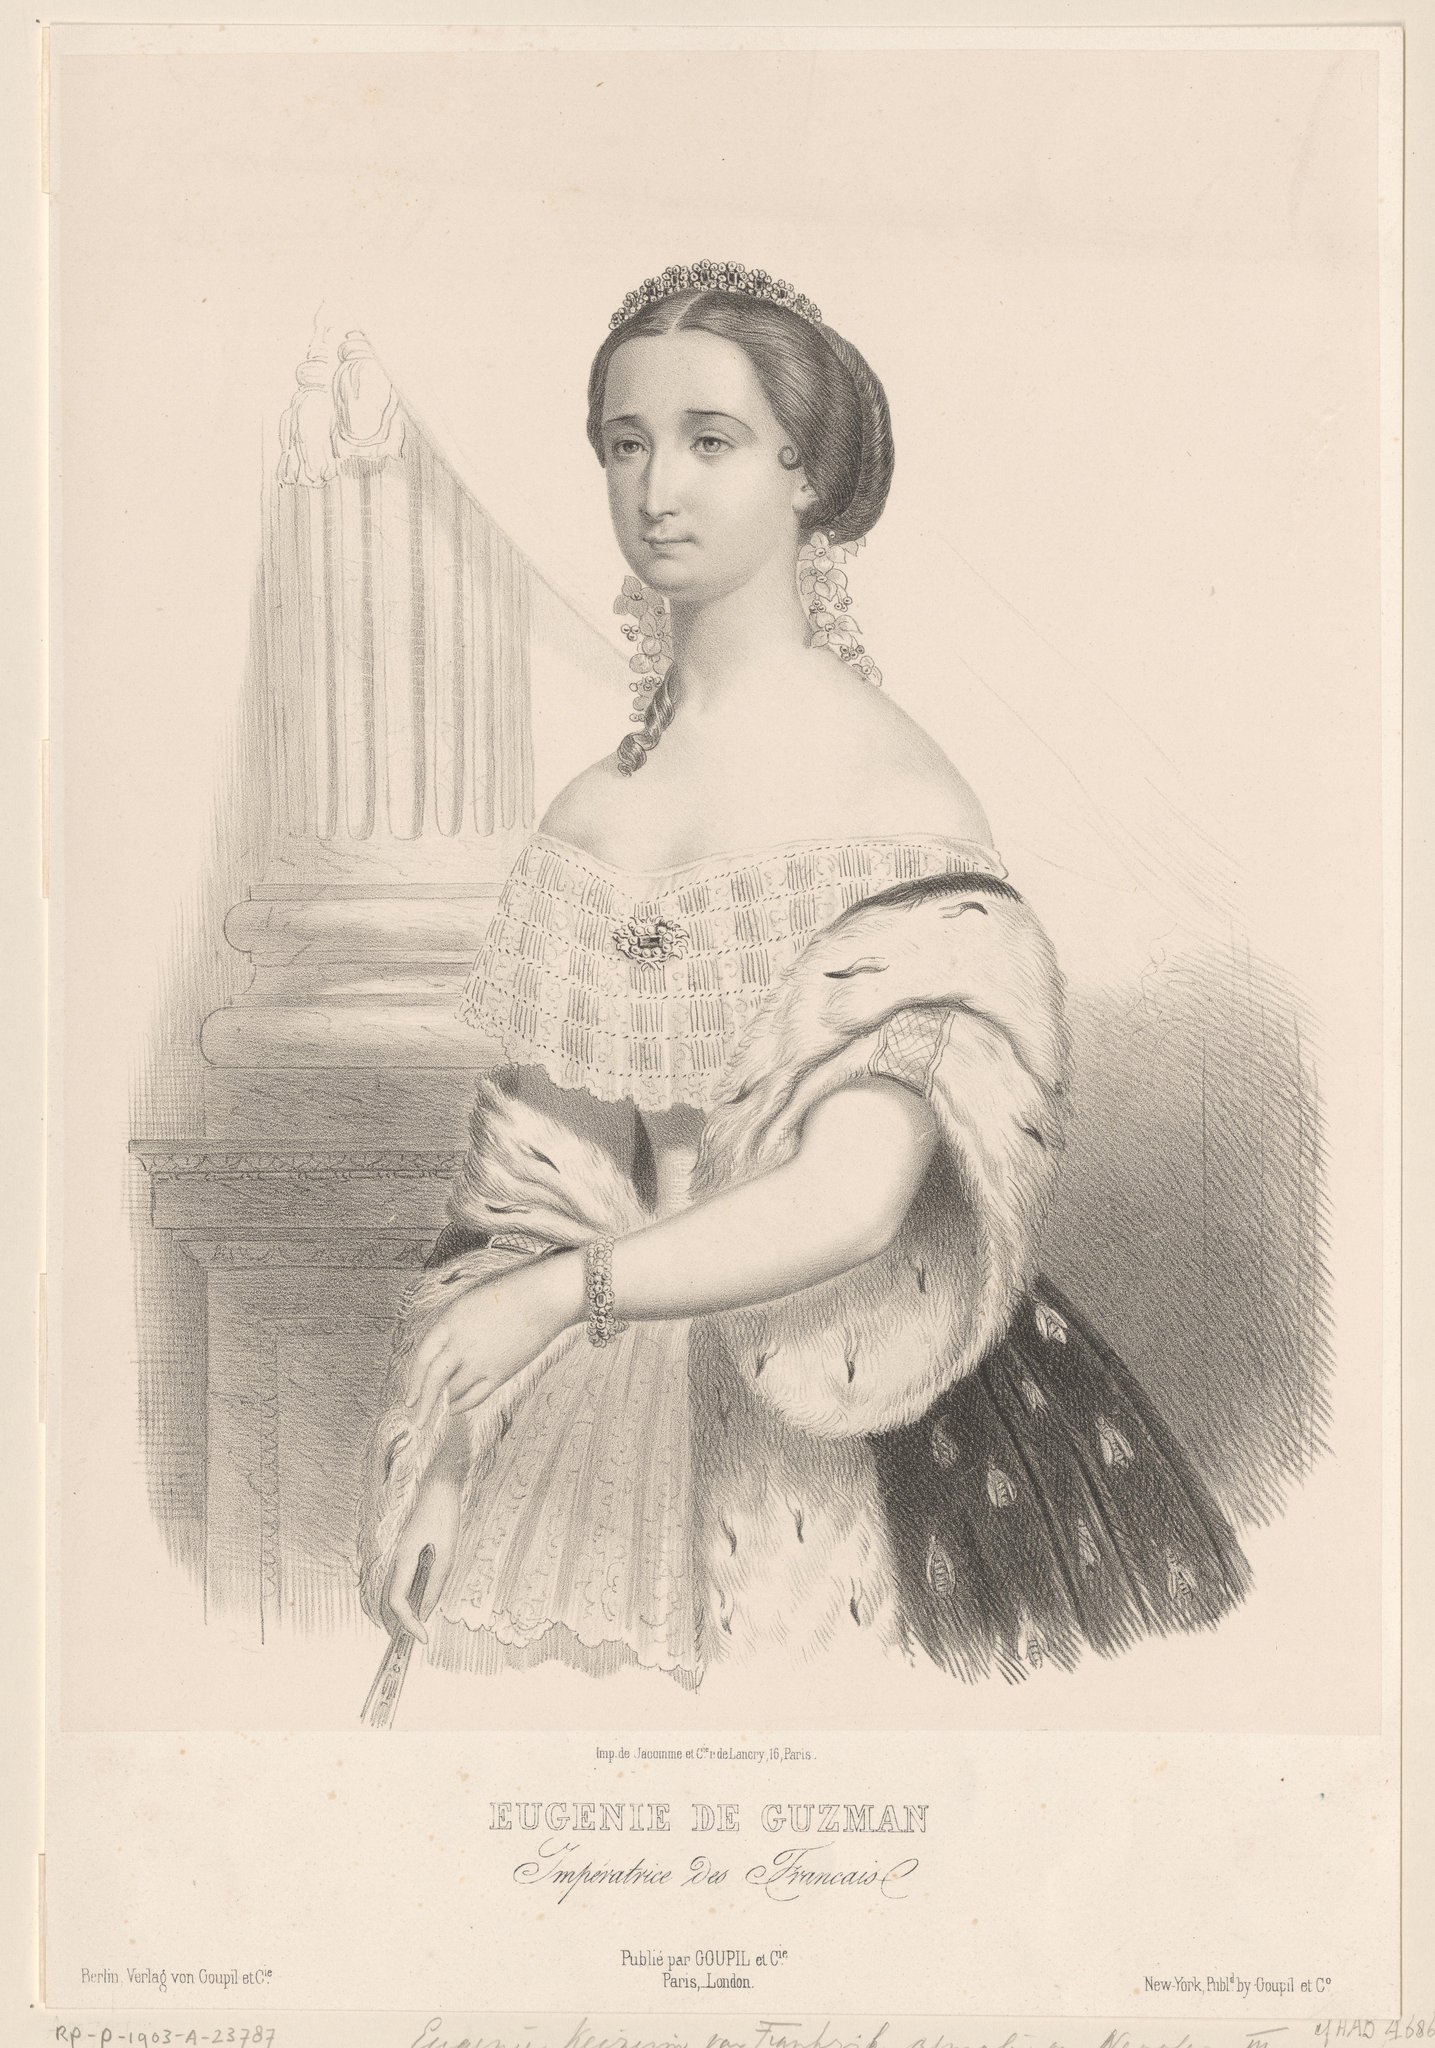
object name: print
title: Portret van Eugénie de Montijo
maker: Anonymous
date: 1853-1871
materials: paper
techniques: lithograph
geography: paris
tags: historical persons - bb - woman, queen, empress, etc. (wife of a ruler)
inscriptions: collector's mark: Lugt 2228